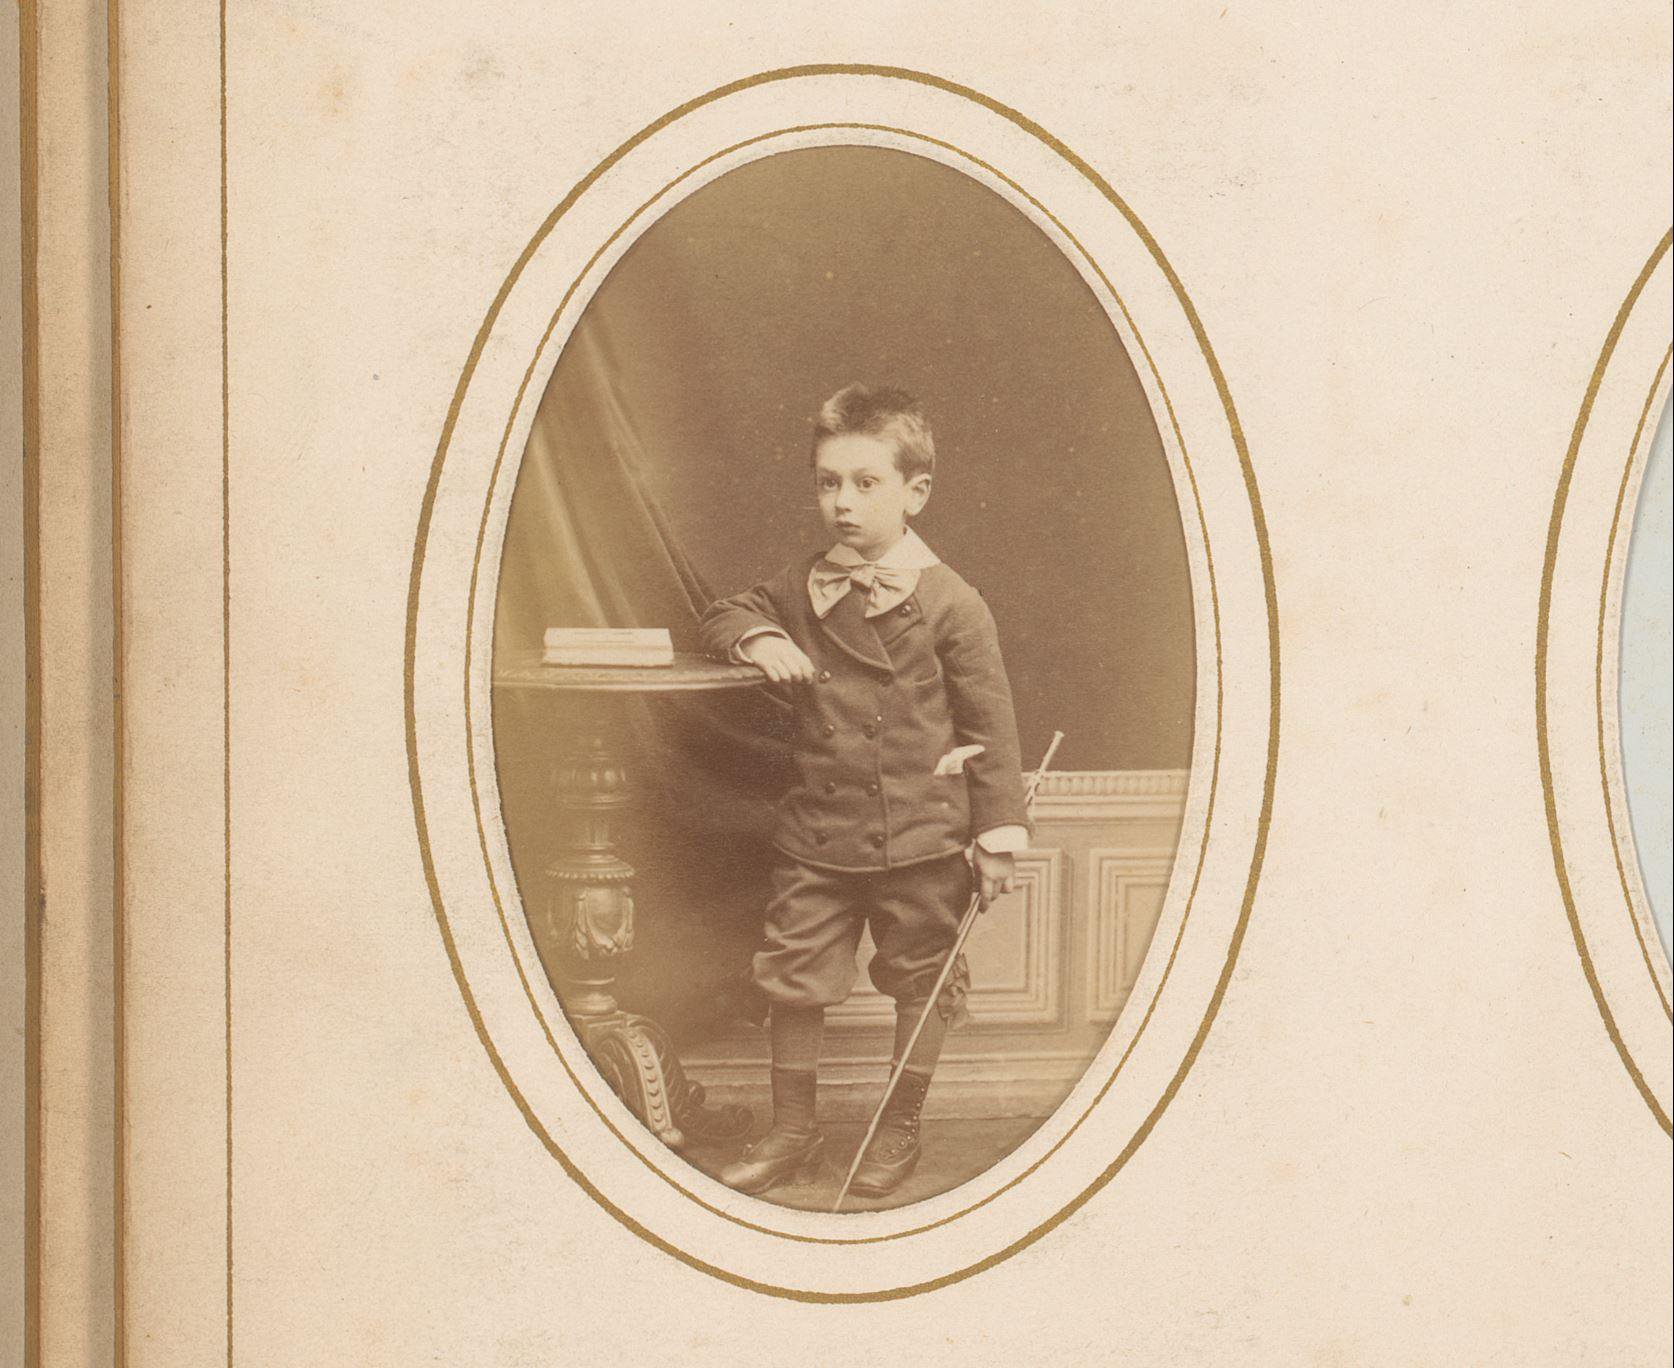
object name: carte de visite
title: Portret van een jongen met stok in de hand, staand bij een tafel met boek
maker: albert delabarre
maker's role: musician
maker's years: 1809-1885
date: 1860-1900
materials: cardboard, photographic support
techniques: albumen print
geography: brussels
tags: boy (child between toddler and youth), walking-stick, staff, historical persons, table, book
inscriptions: inscription: ‘PHOTOGRAPHIE PARISIENNE/ 18, Rue Fossé aux Loups, 18/ (Place de la Monnaie)/ BRUXELLES/ Les clichés sont conservés.’